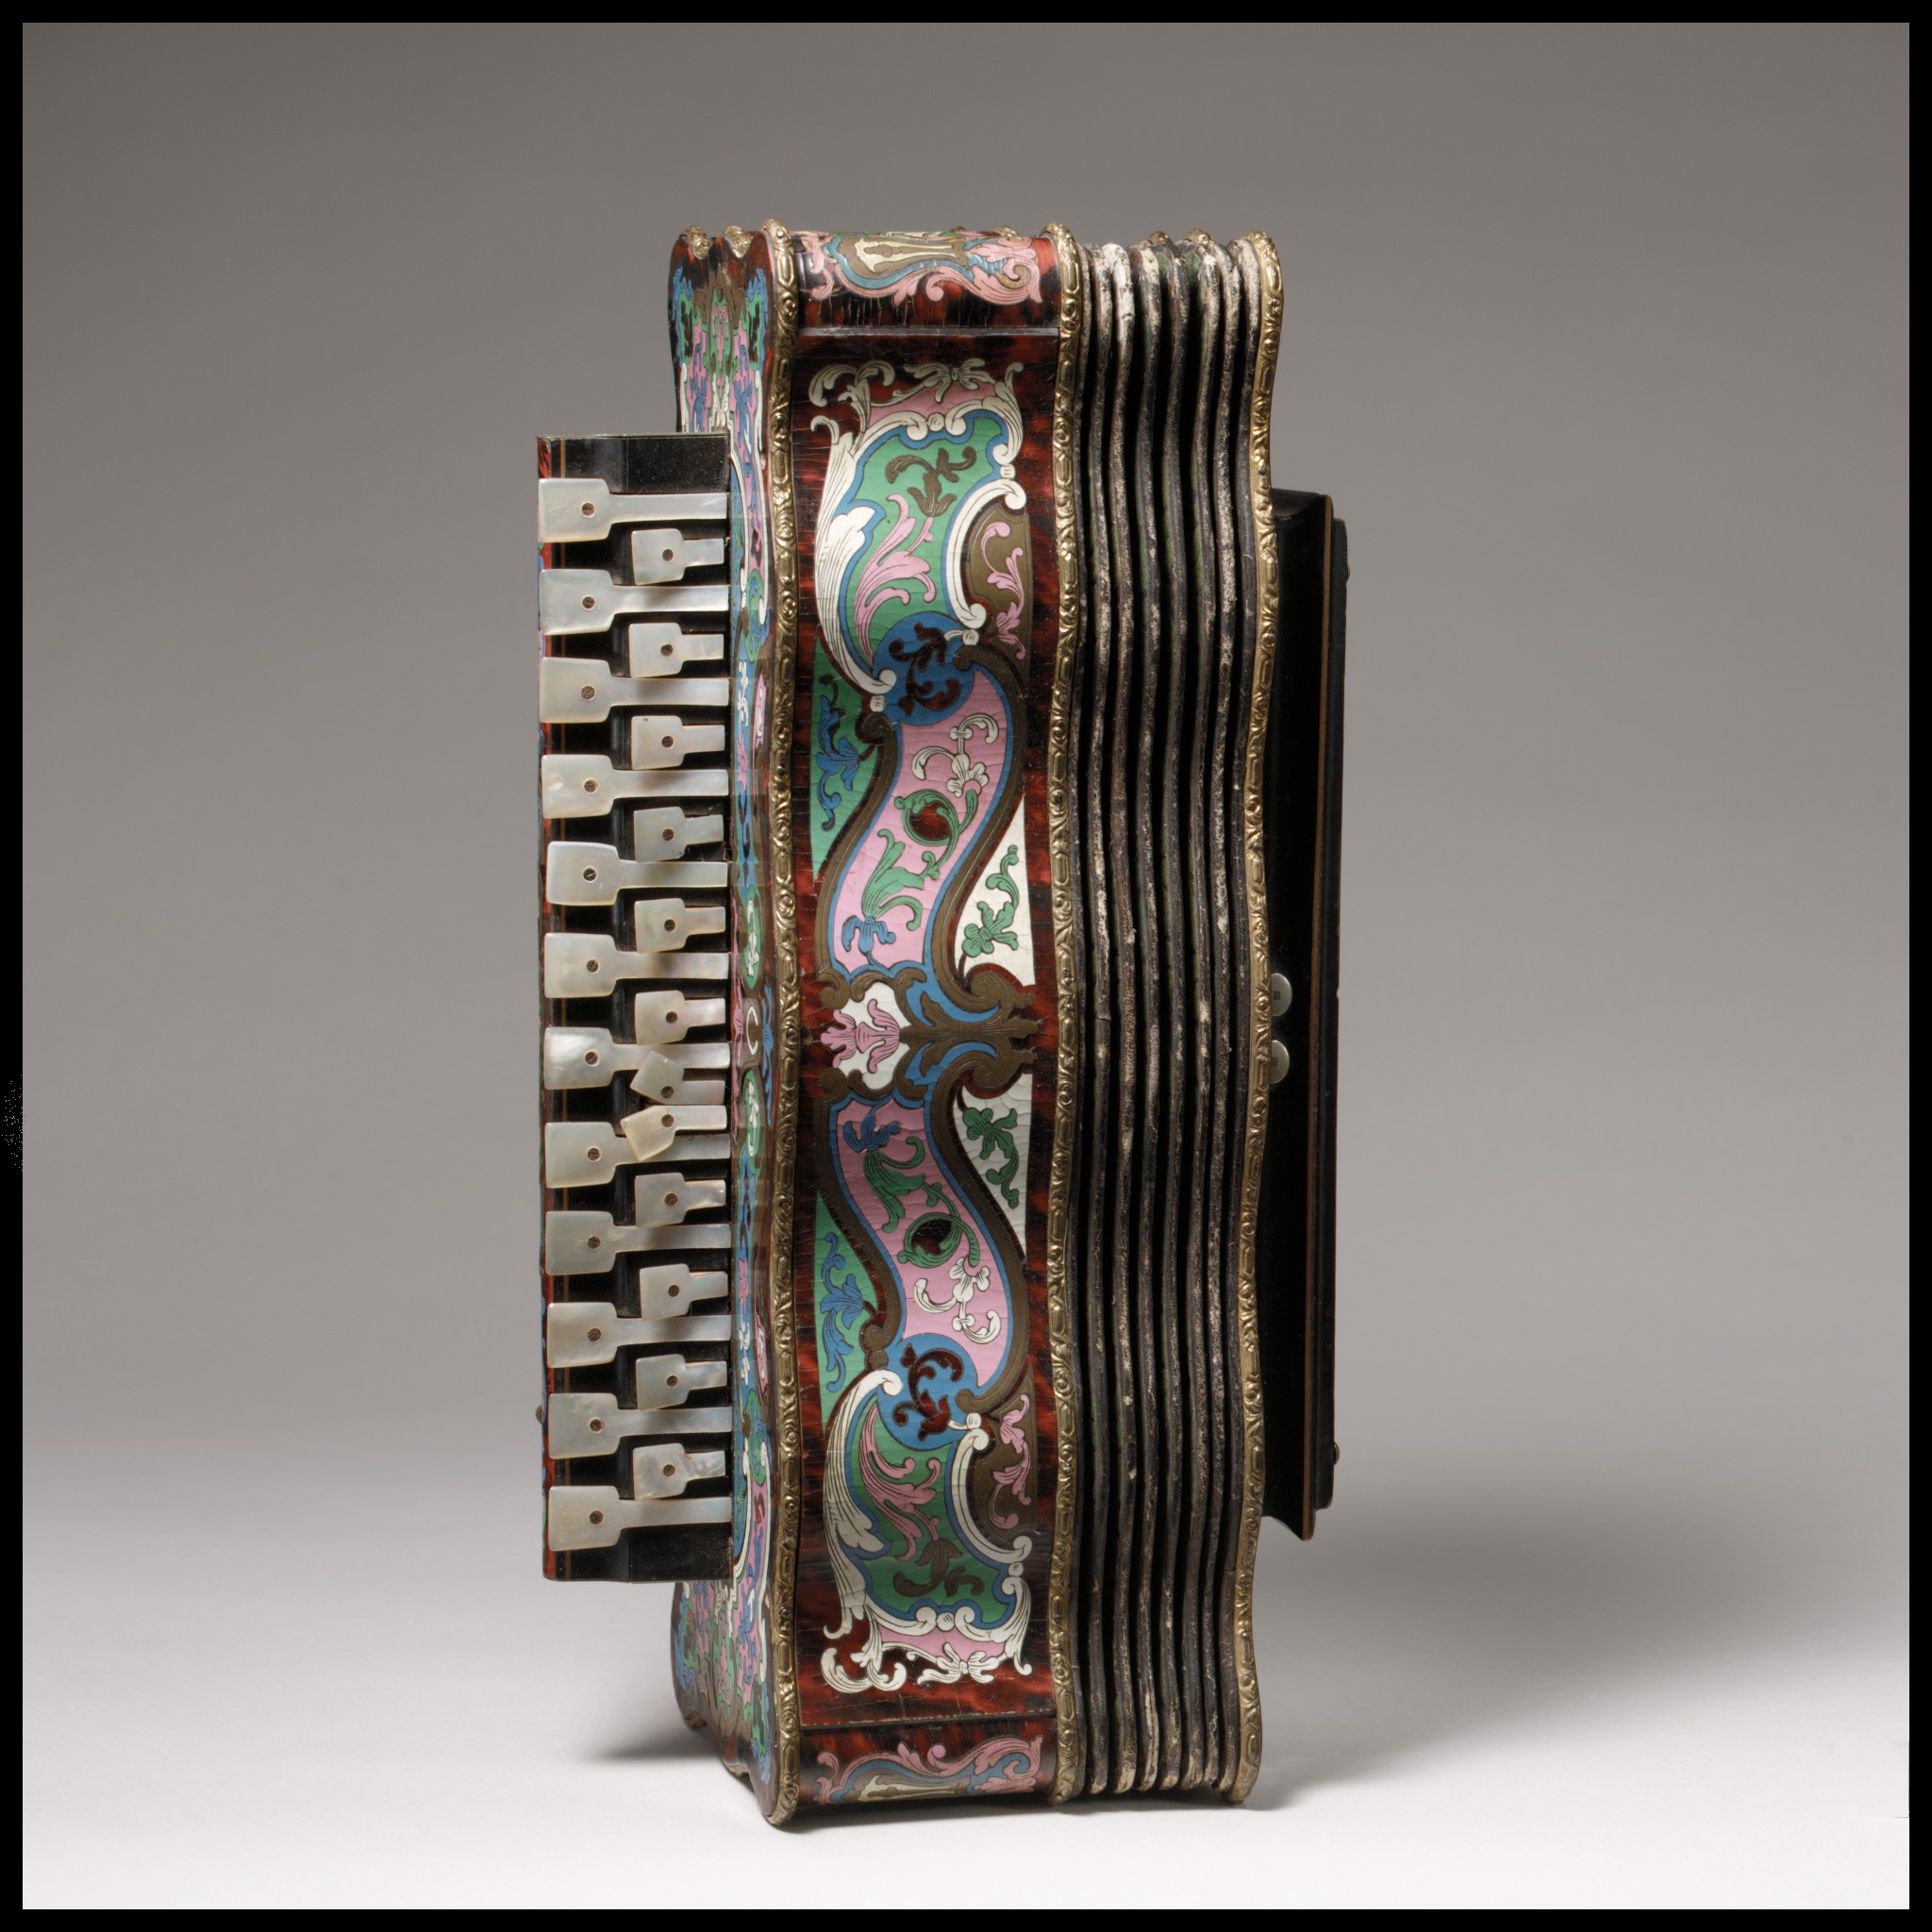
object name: accordion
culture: french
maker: alexandre pere & fils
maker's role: maker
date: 1850-1855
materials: brass, foil, gilt, metal, mother of pearl, silver, shell, wood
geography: france